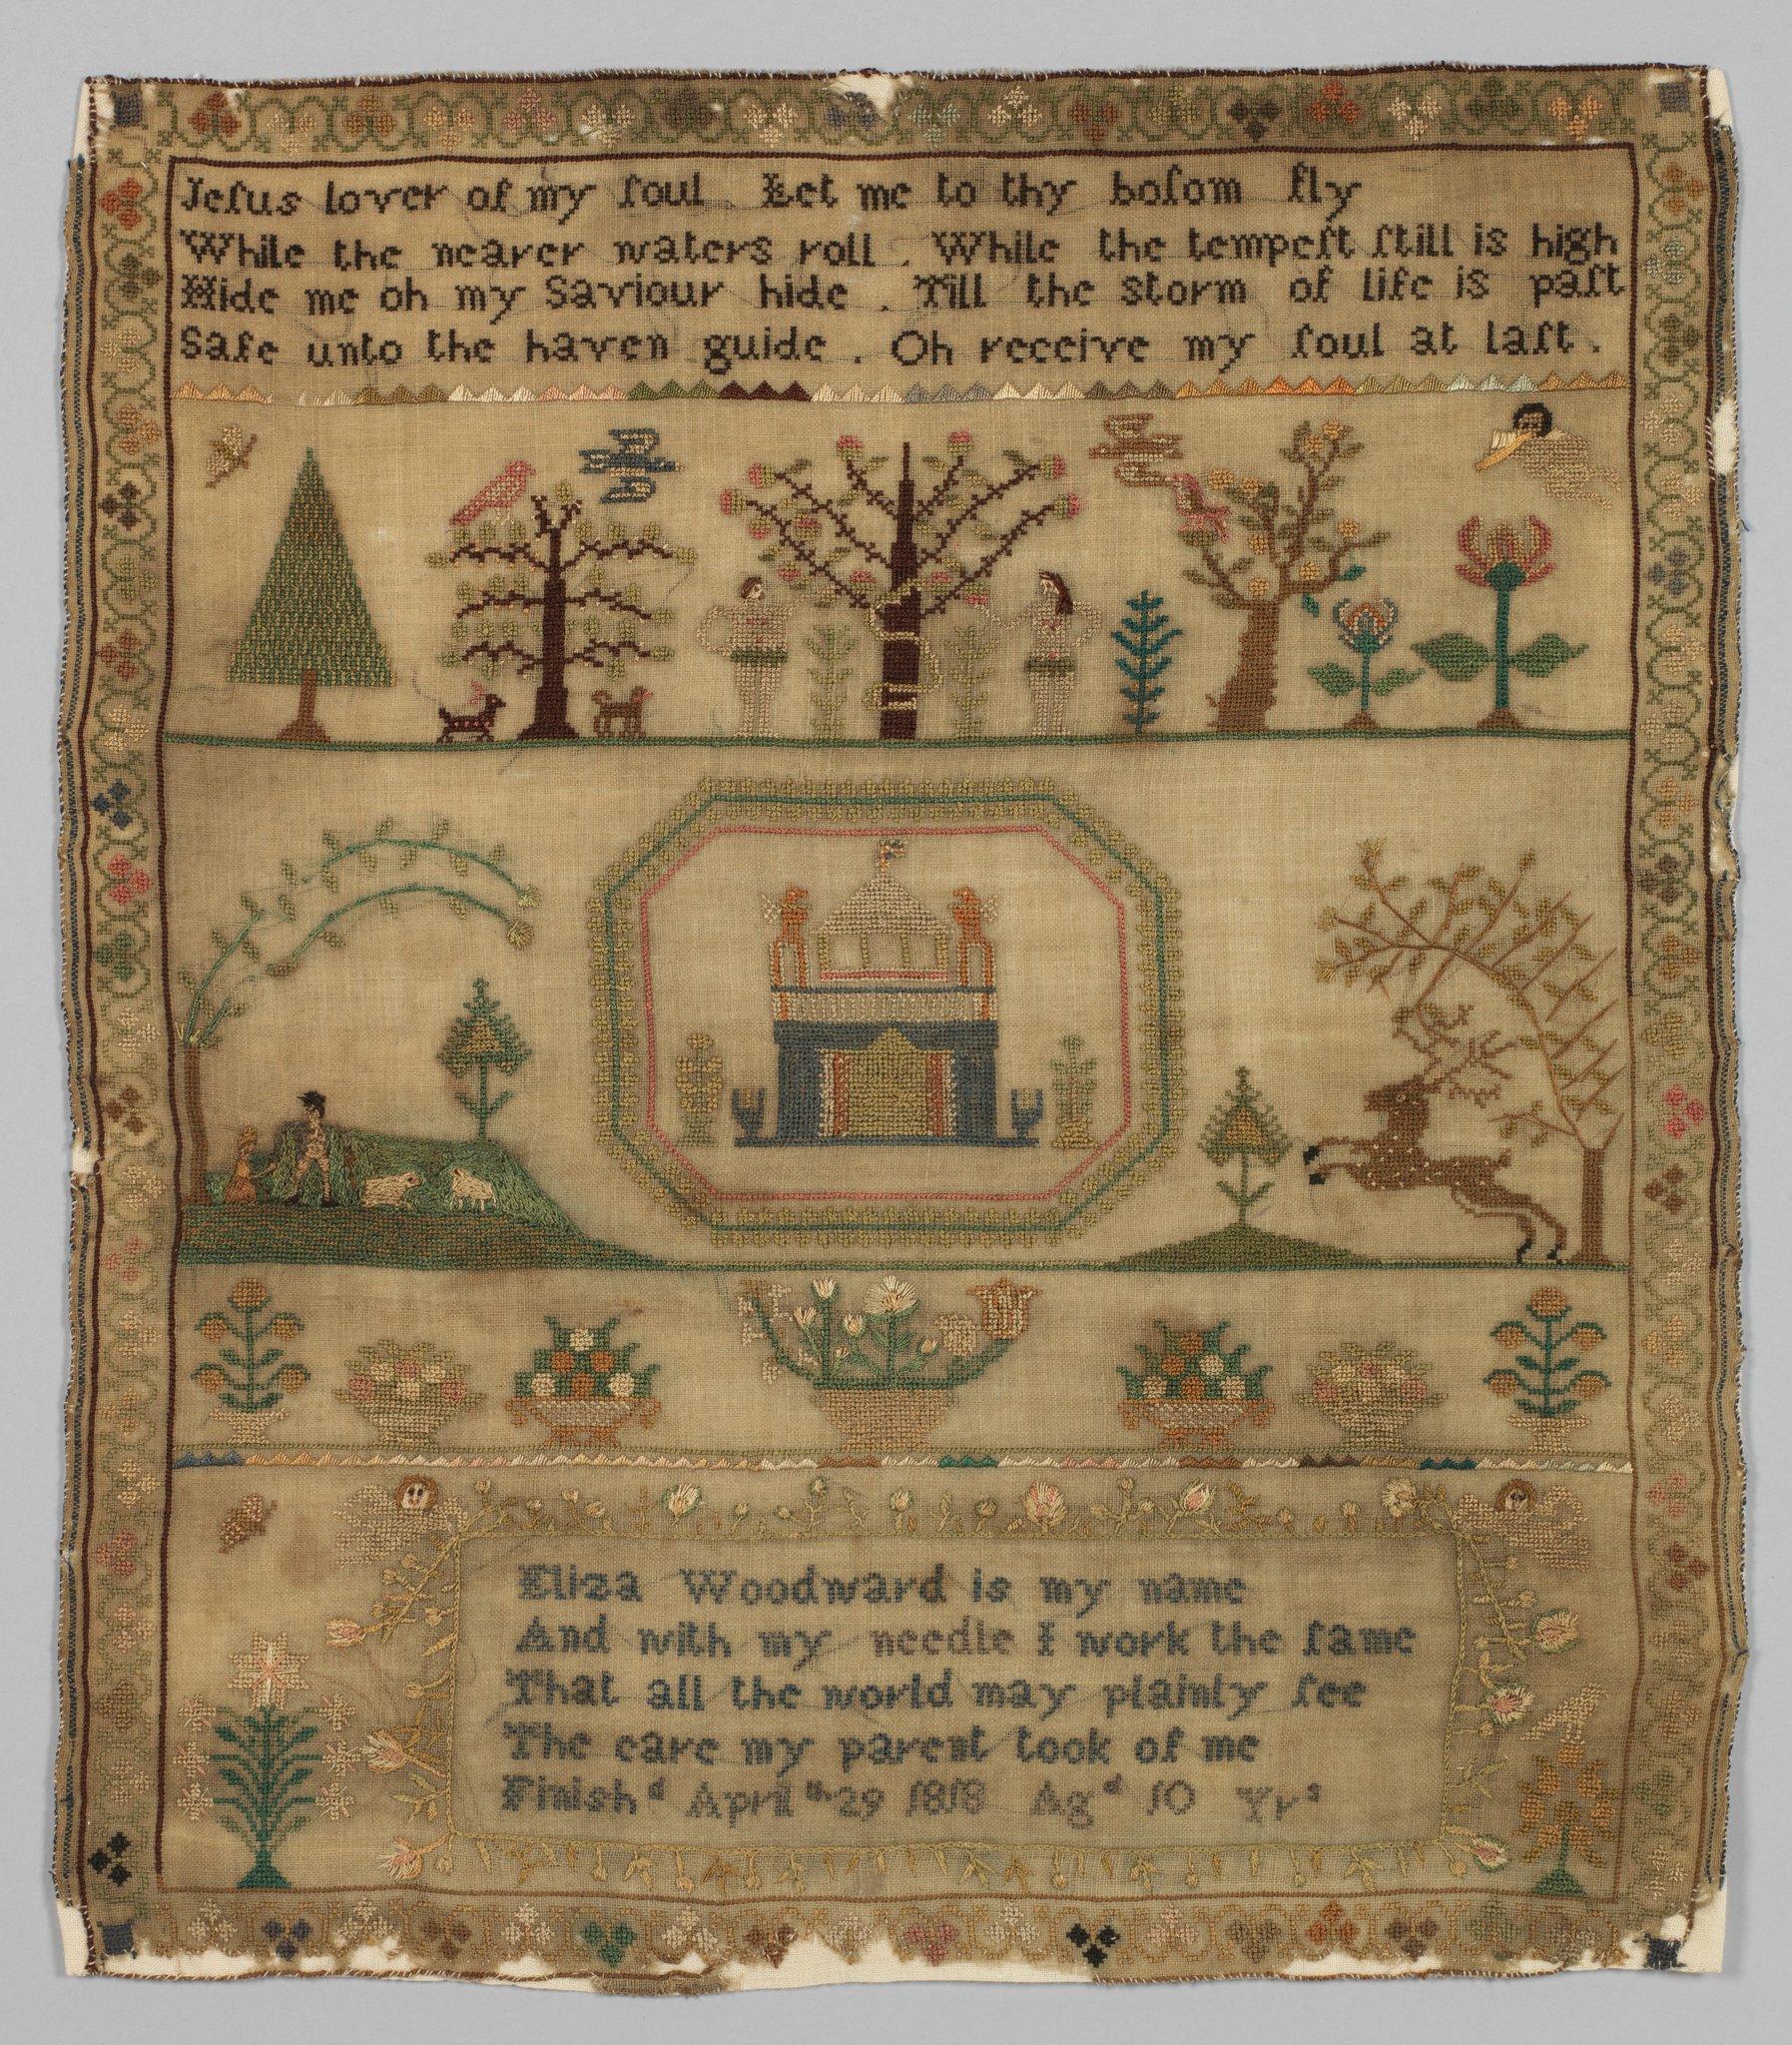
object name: sampler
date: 1818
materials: canvas, silk, wool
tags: deer,trees,adam,eve